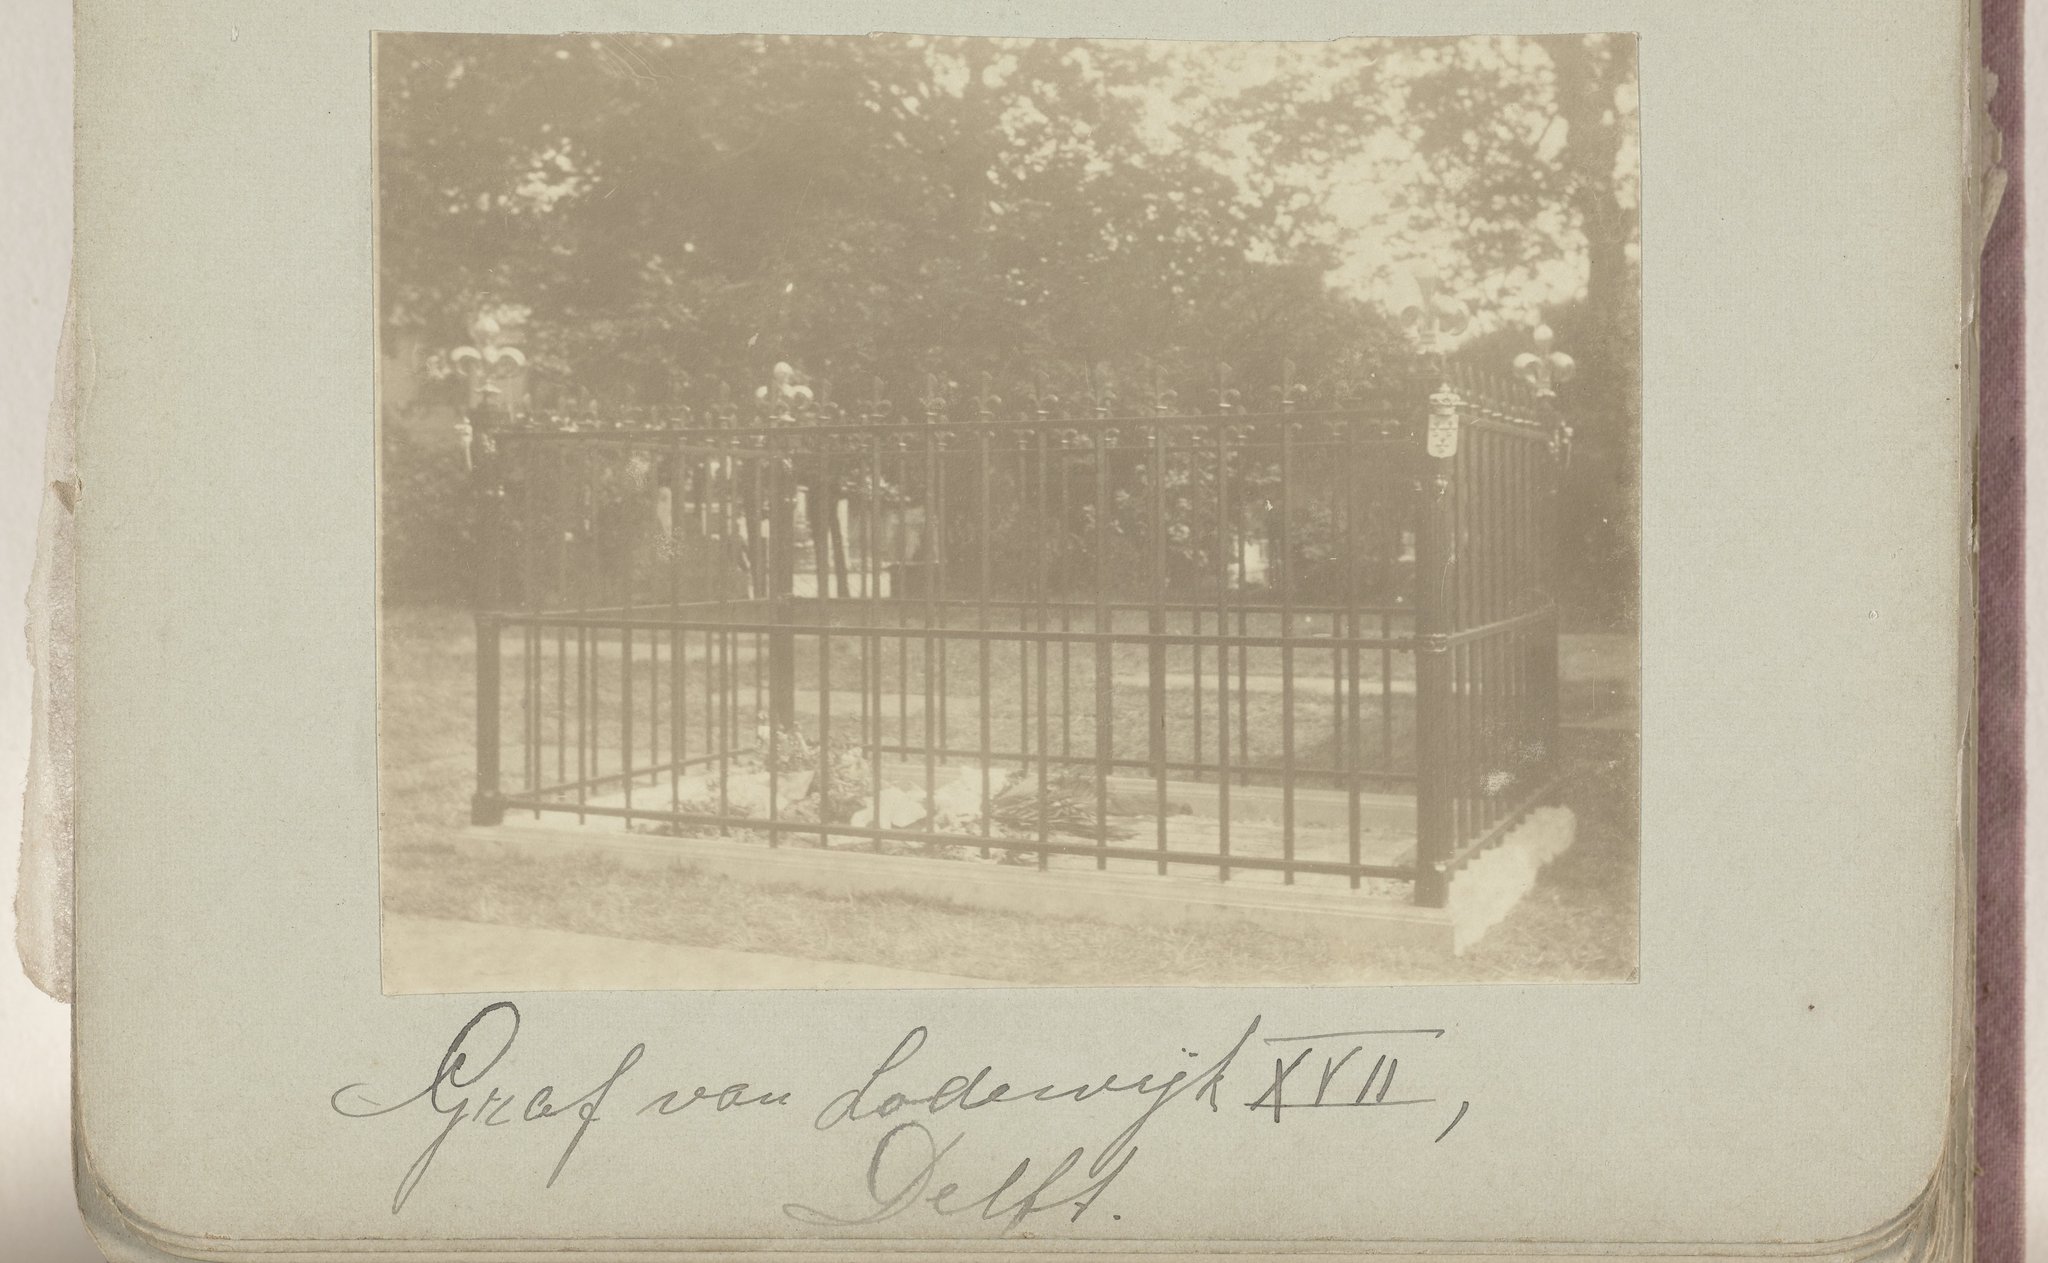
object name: photograph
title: Graf van Lodewijk XVII, Delft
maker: david vermeulen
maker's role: fotograaf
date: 1901-1910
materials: paper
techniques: gelatin silver print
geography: delft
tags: karl wilhelm naundorff, grave, tomb, delft